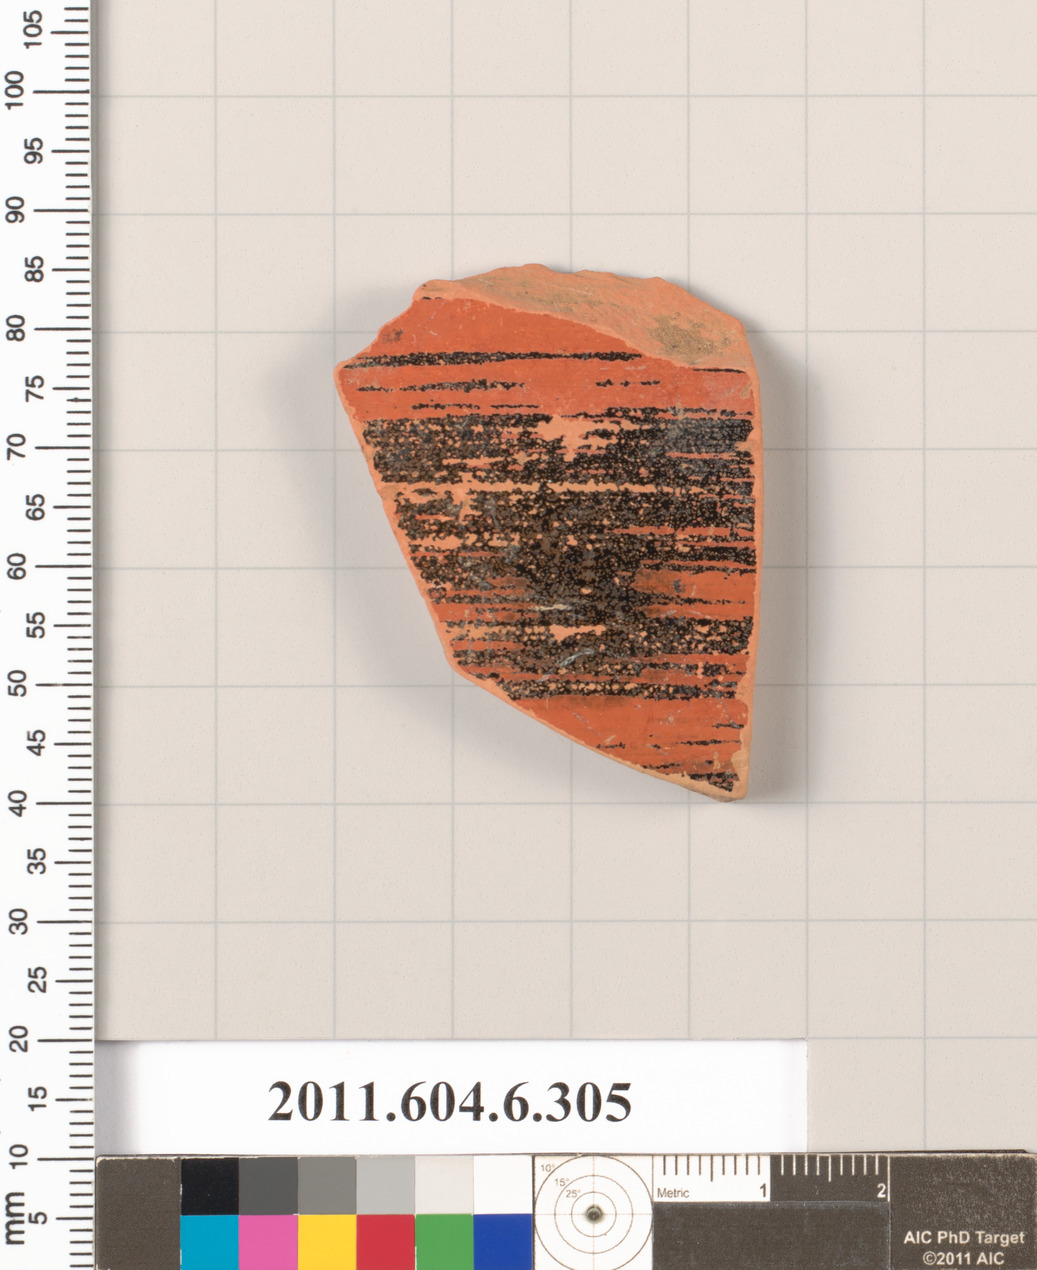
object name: undetermined open shape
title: Terracotta fragment of an open shape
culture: greek, attic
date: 600-401 BCE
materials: terracotta